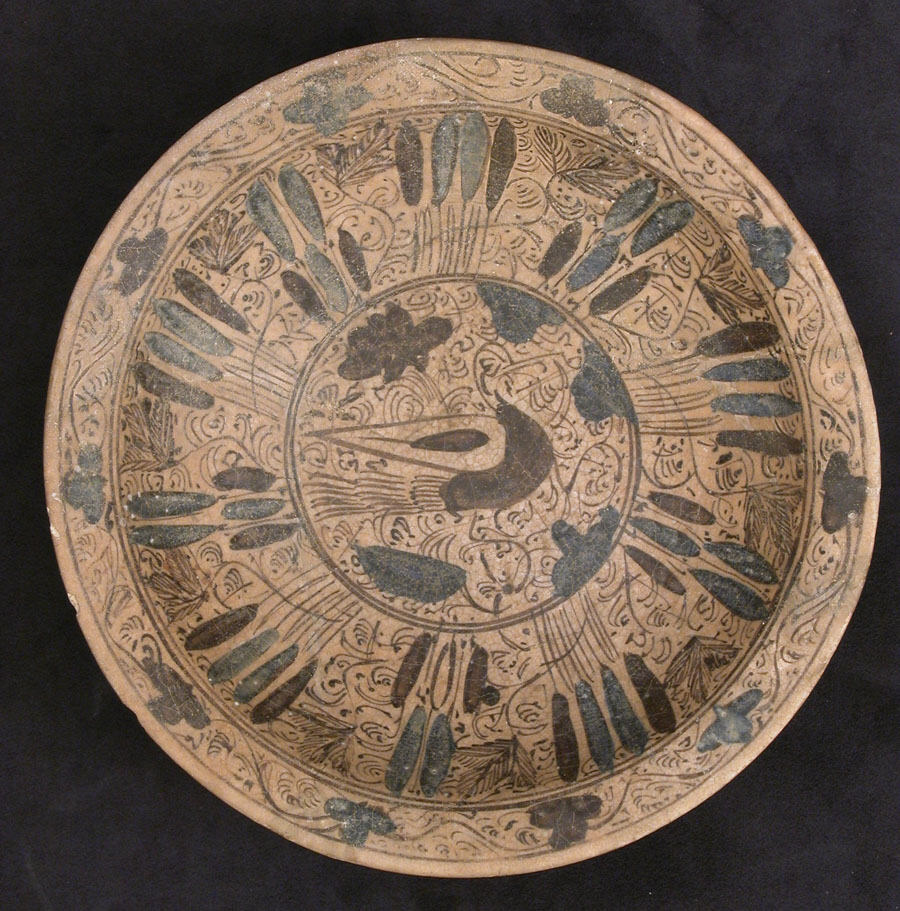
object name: dish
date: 1201-1300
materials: earthenware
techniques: glazing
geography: iran